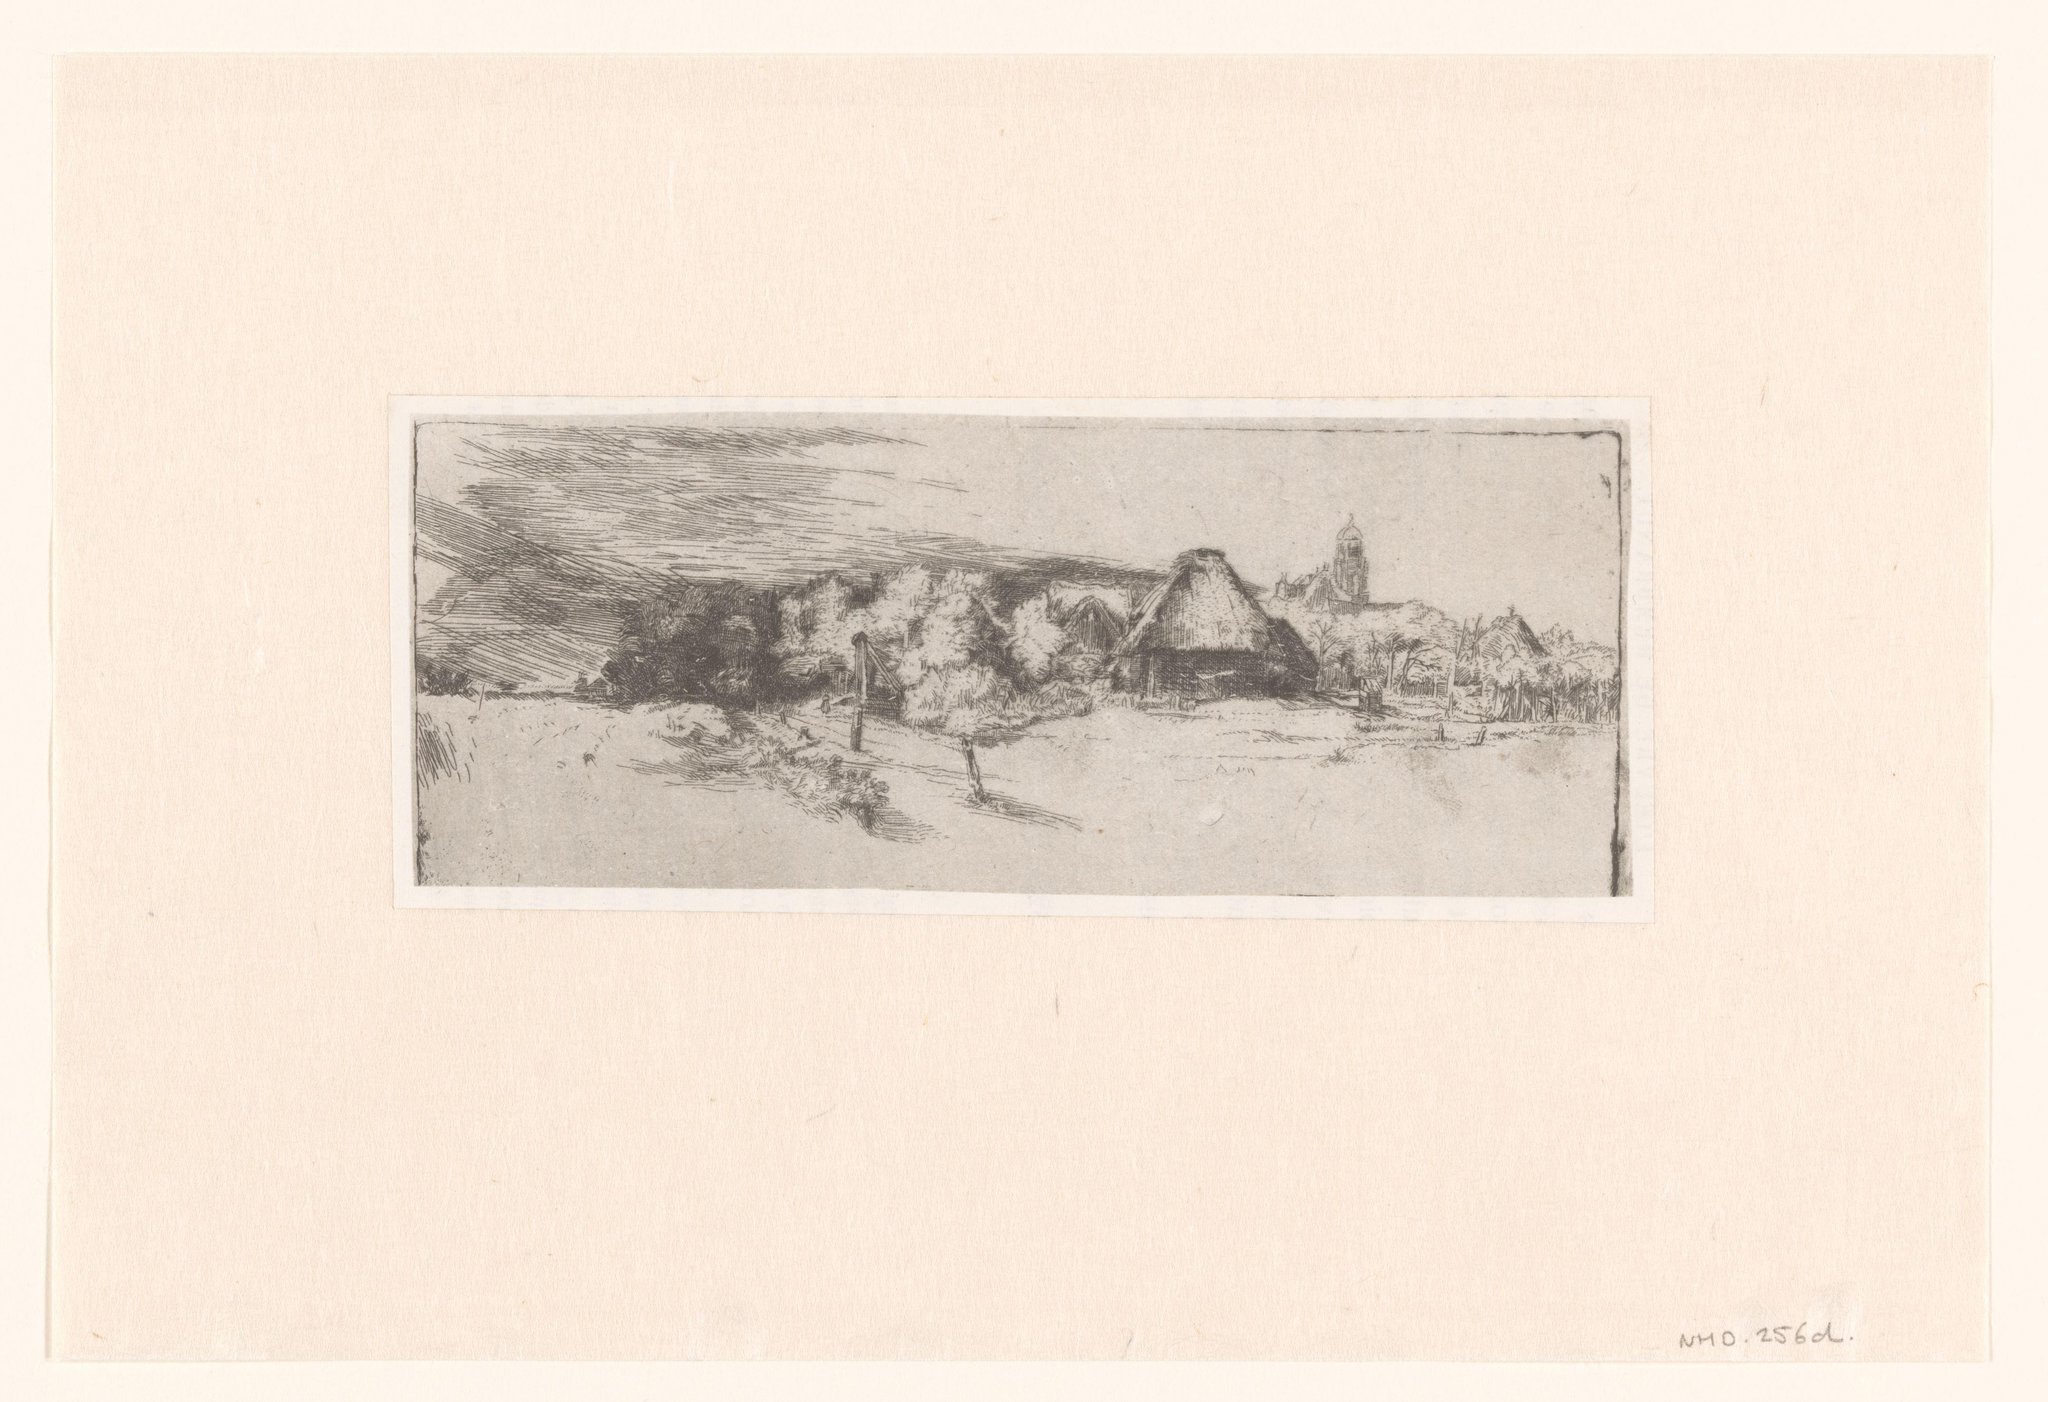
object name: print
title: Landscape with a farm building and the 'house with the tower'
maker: léopold flameng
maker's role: print maker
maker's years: 1831-1911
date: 1841-1911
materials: paper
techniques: etching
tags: city-view, and landscape with man-made constructions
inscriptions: collector's mark: Lugt 2760, collector's mark: Lugt 2228